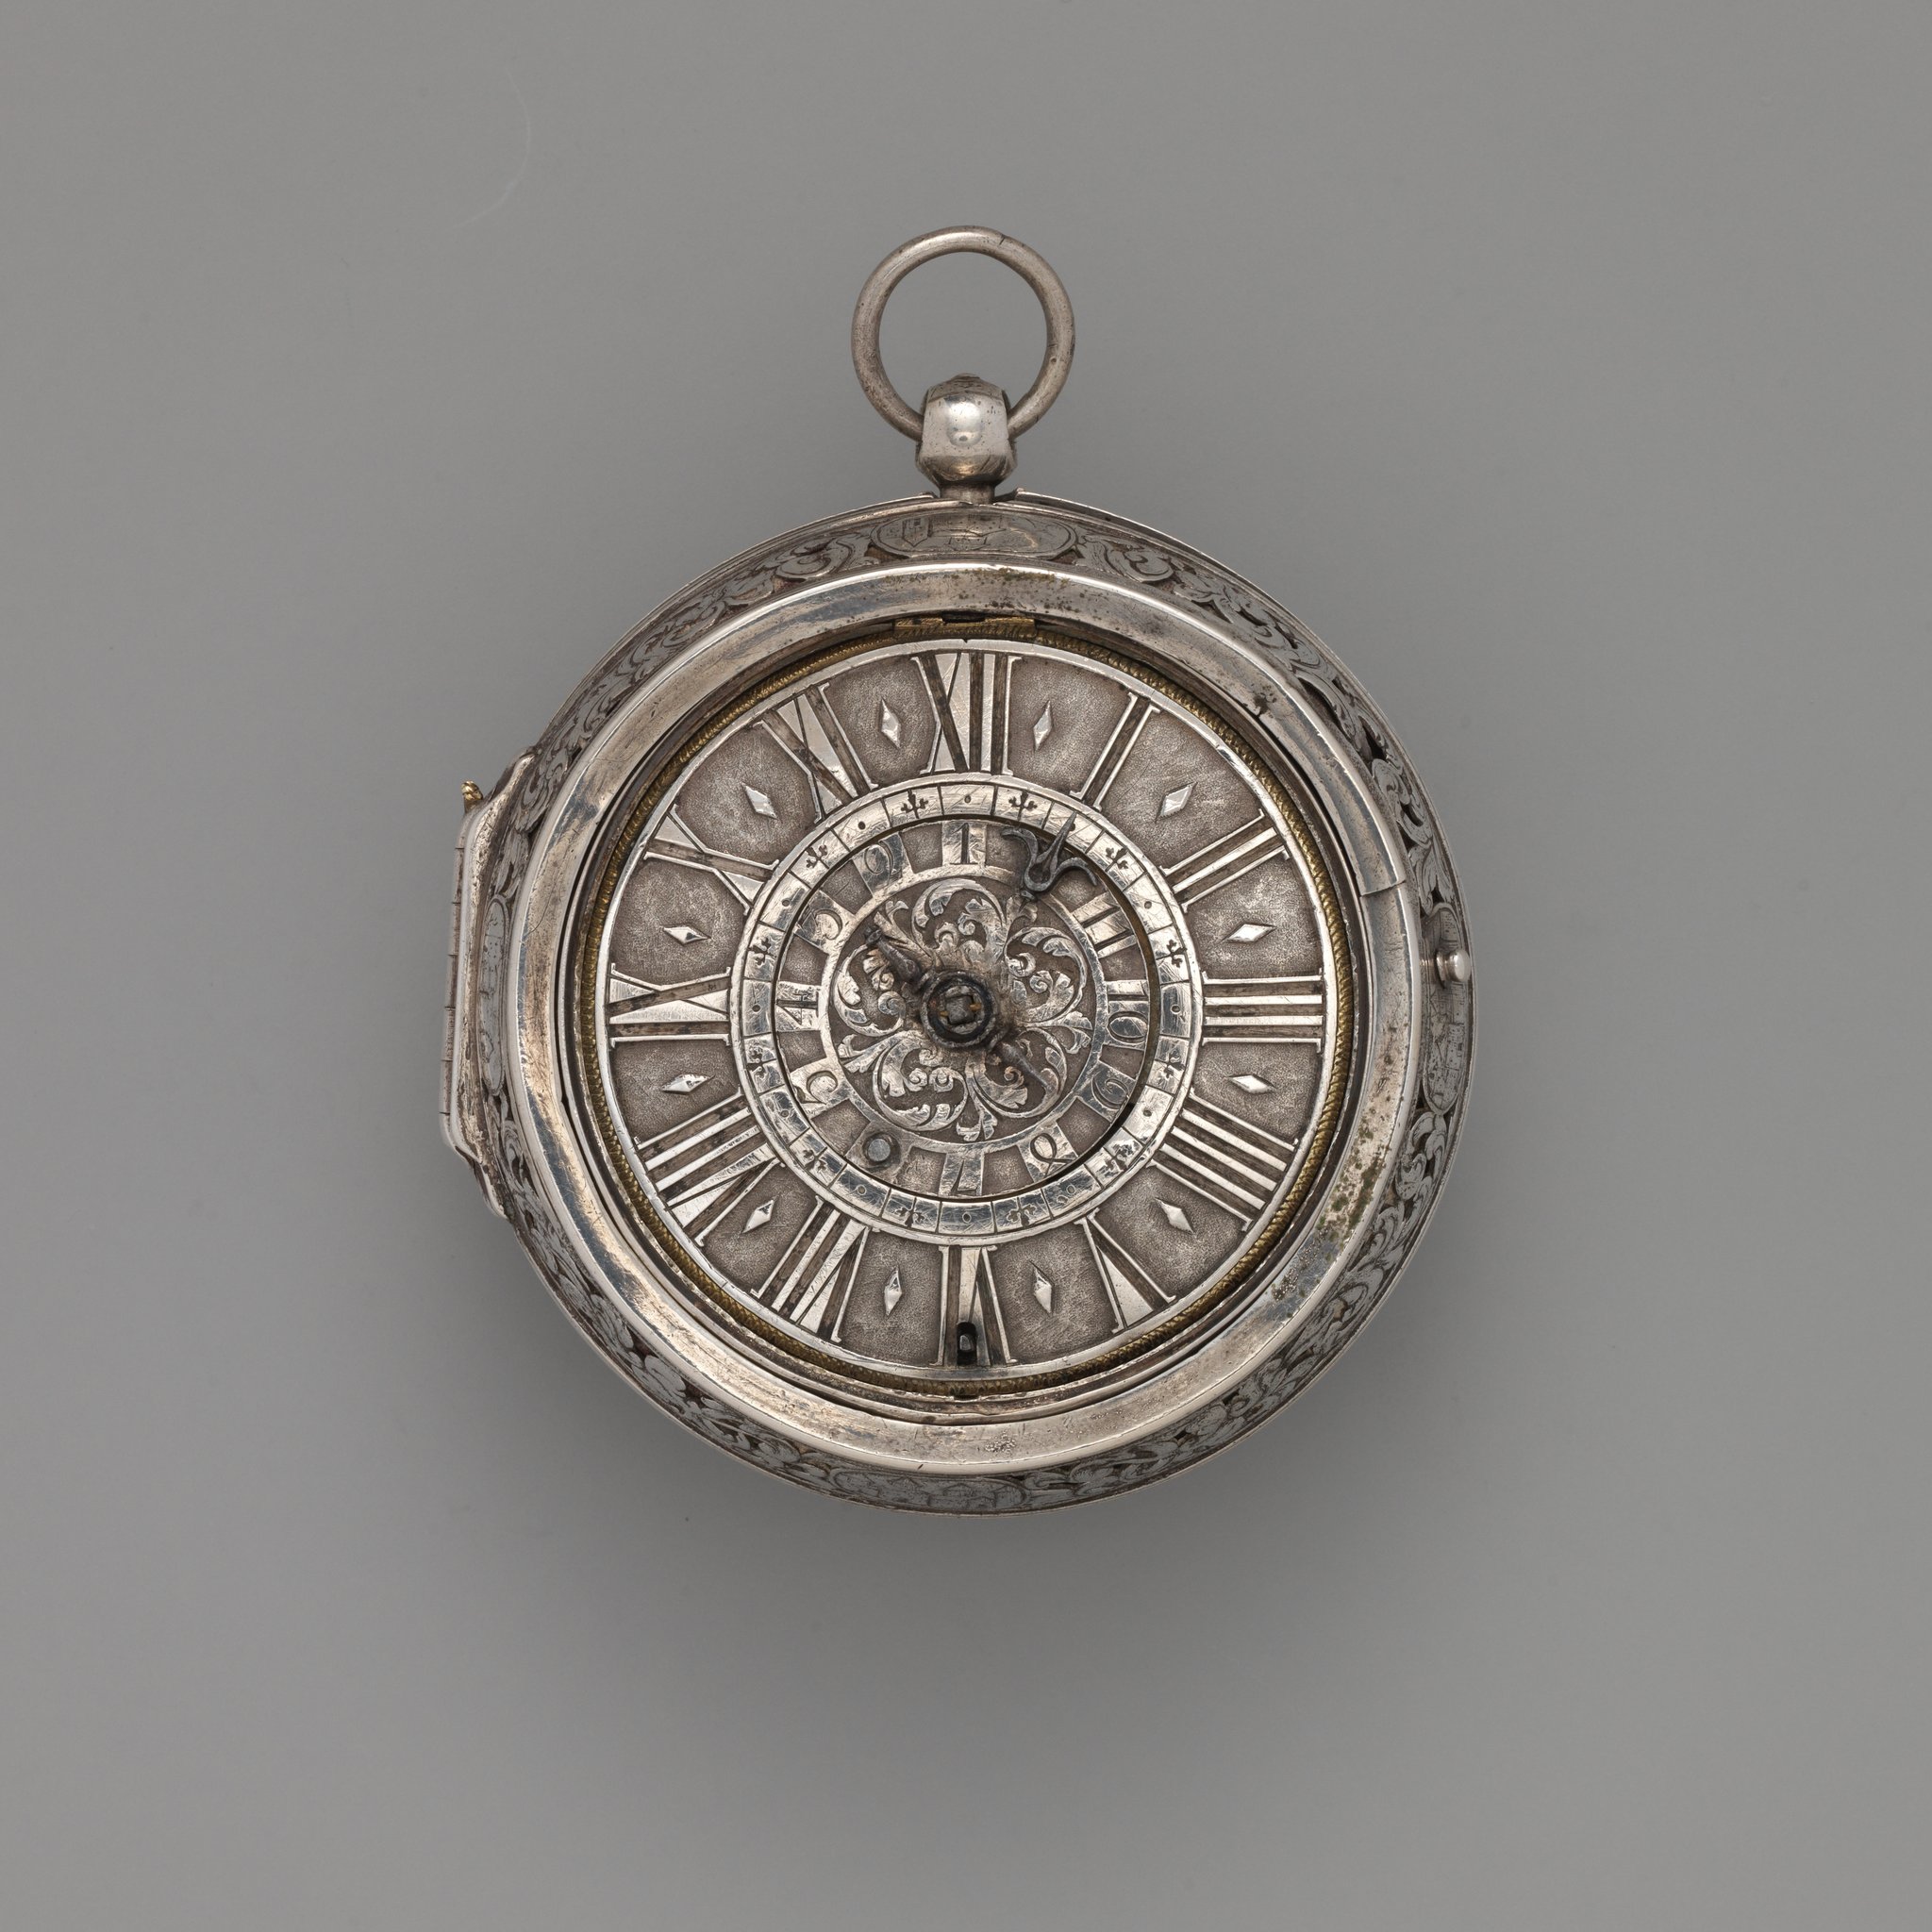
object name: clock watch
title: Clock-watch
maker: daniel quare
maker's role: maker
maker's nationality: british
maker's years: 1647-1724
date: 1690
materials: silver